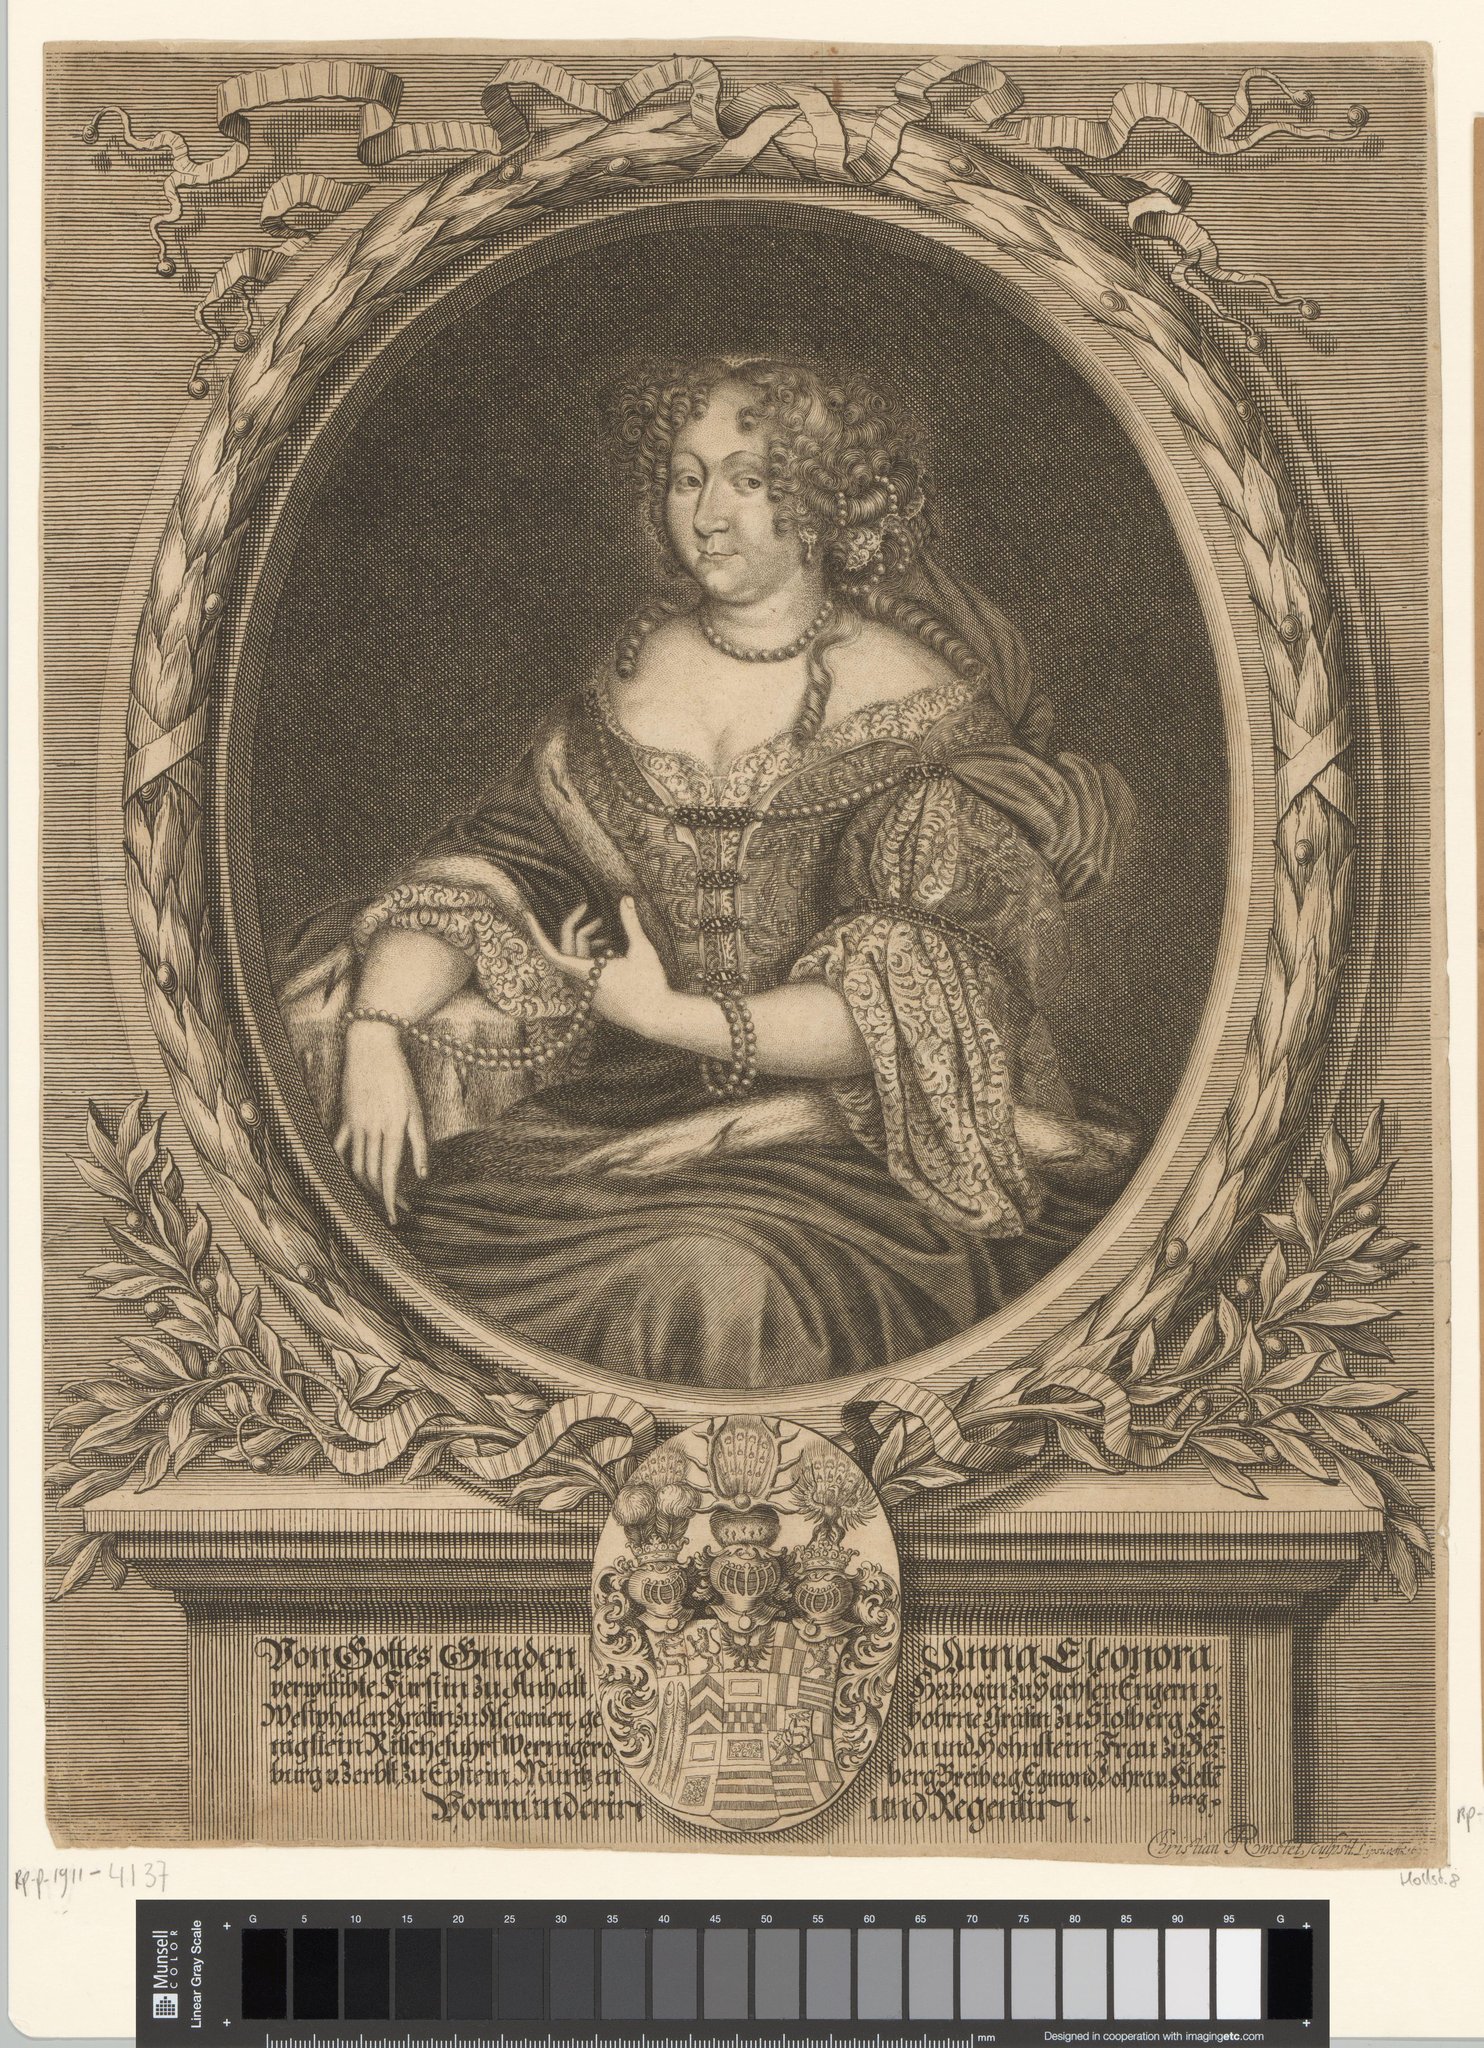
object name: print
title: Portret van Anna Eleonore Anhalt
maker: christian romstet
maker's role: print maker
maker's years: 1640-1721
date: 1665-1721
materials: paper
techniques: engraving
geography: leipzig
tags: historical persons - bb - woman, pearl; pearl necklace, armorial bearing, heraldry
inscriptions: collector's mark: Lugt 2228